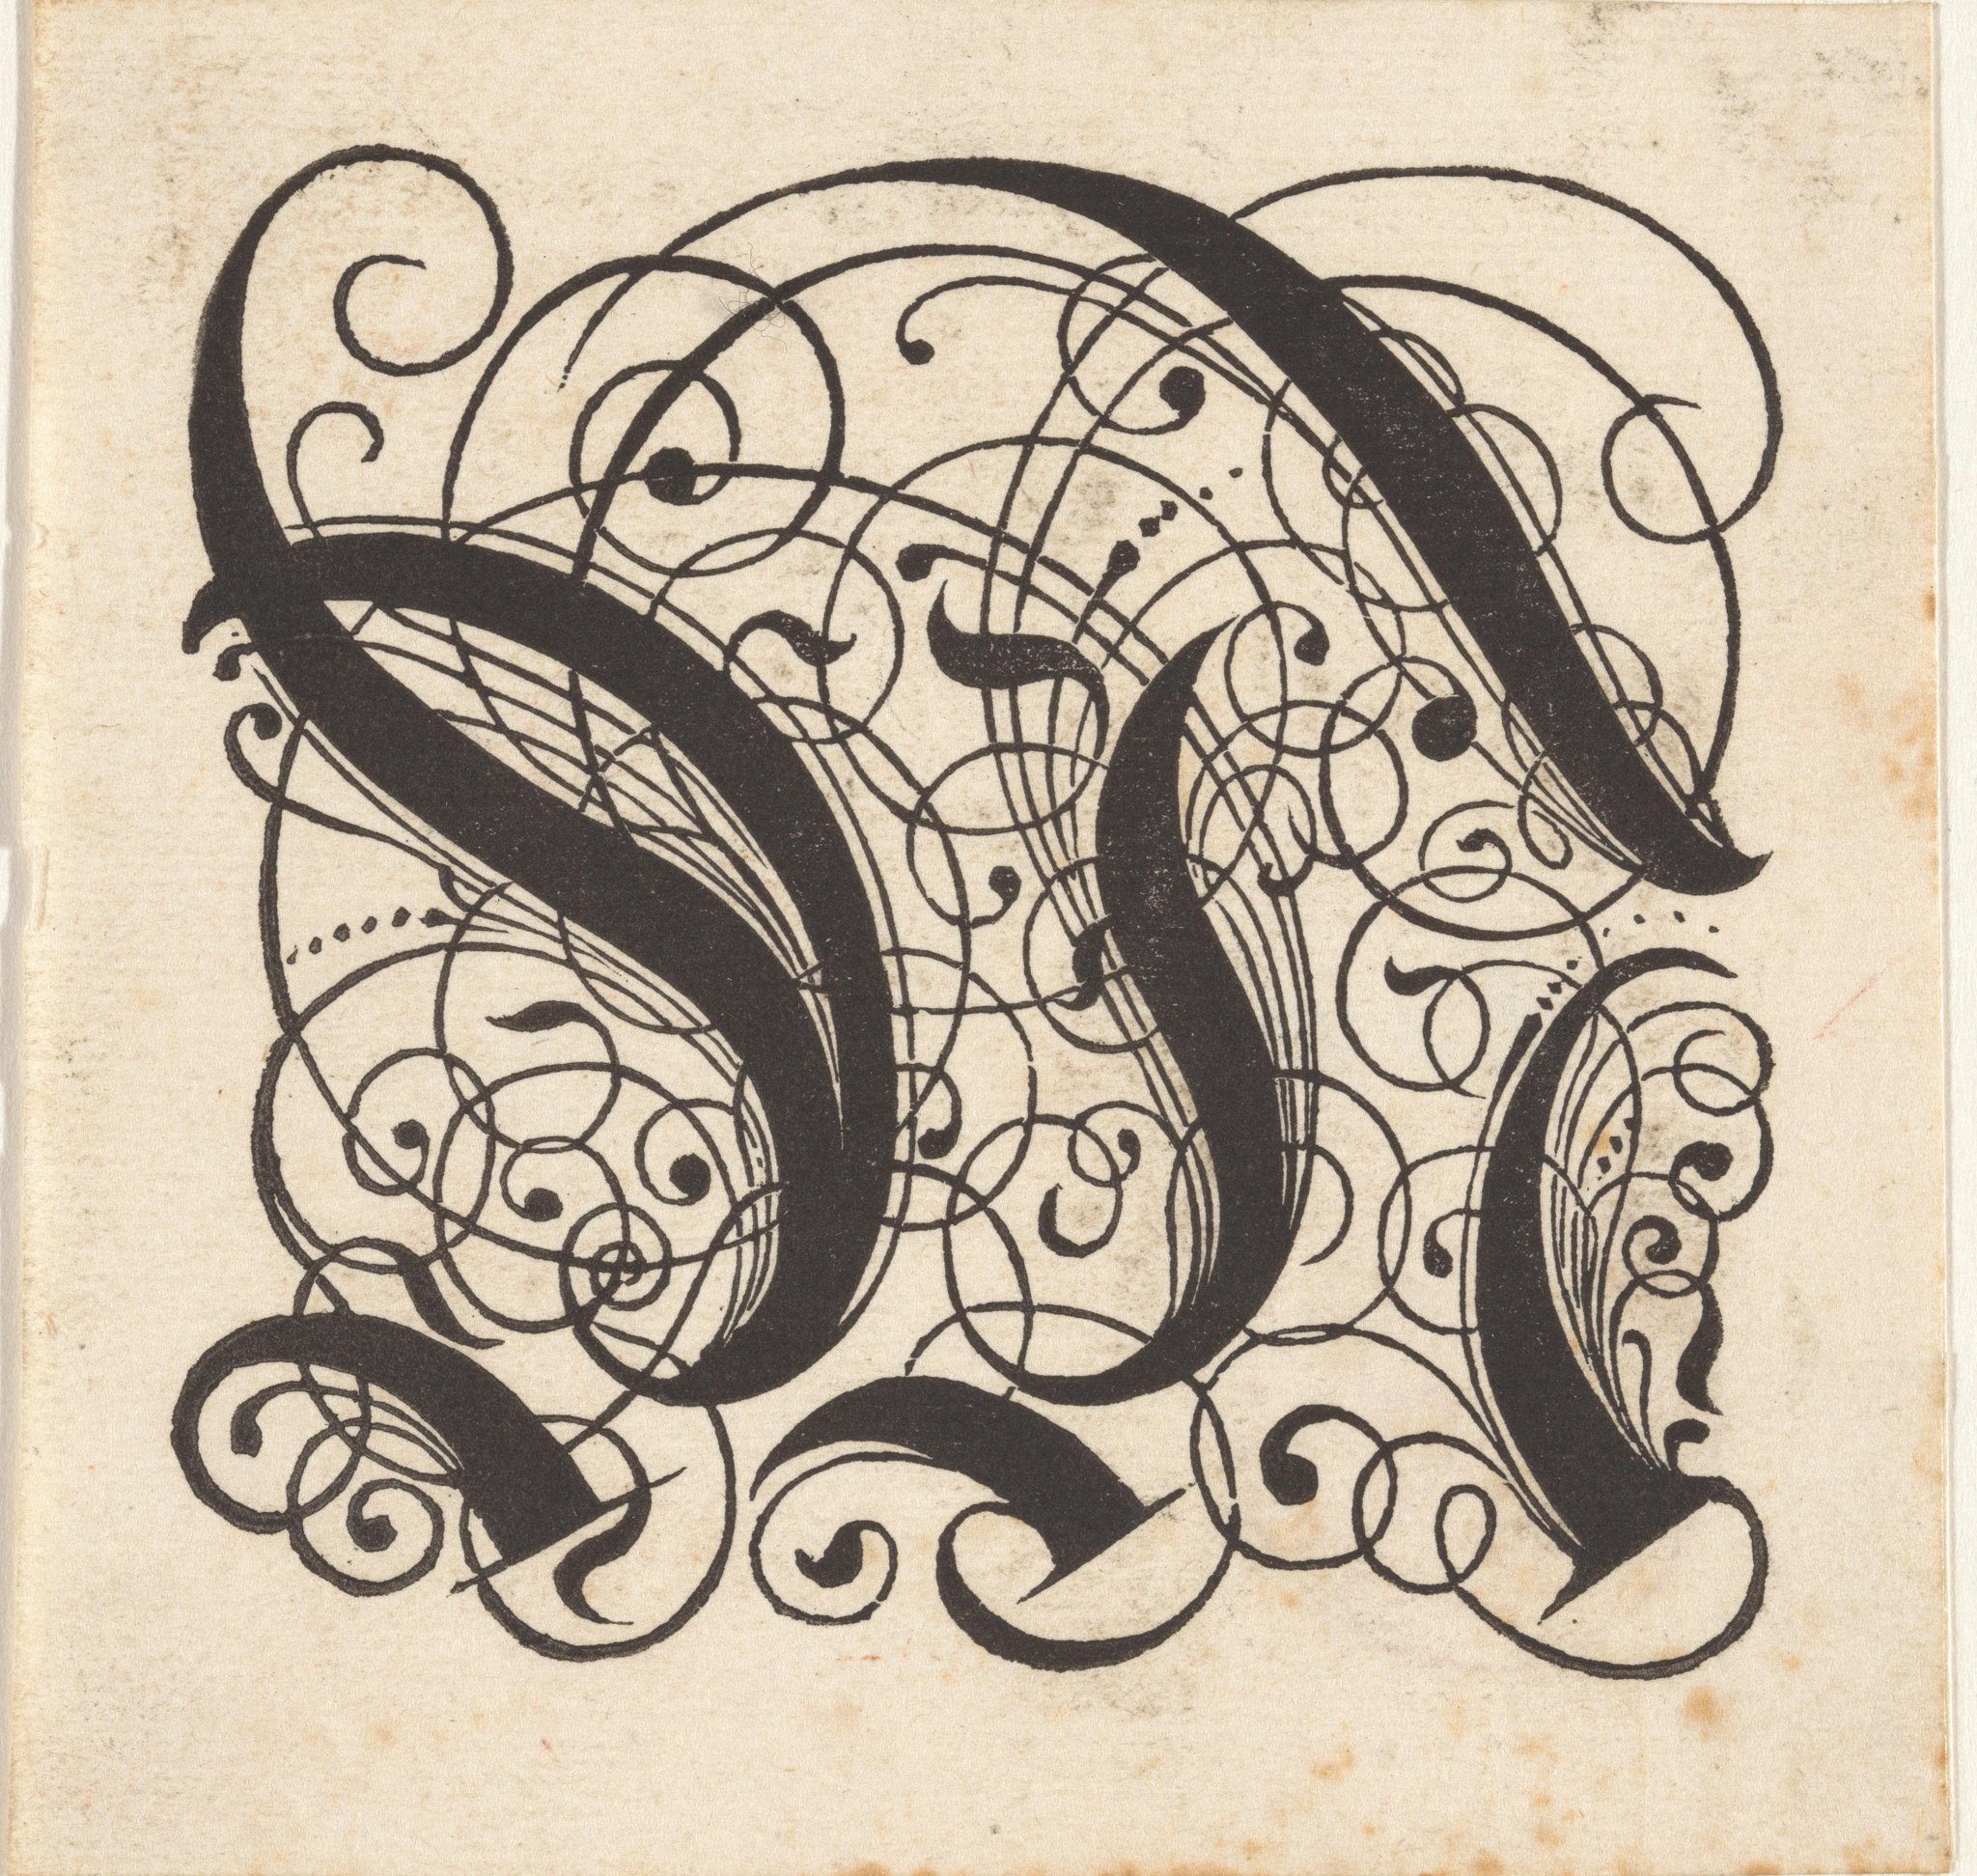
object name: print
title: Letter M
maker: Anonymous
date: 1600-1699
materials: paper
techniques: woodcut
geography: netherlands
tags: fancy letters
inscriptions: collector's mark: Lugt 240